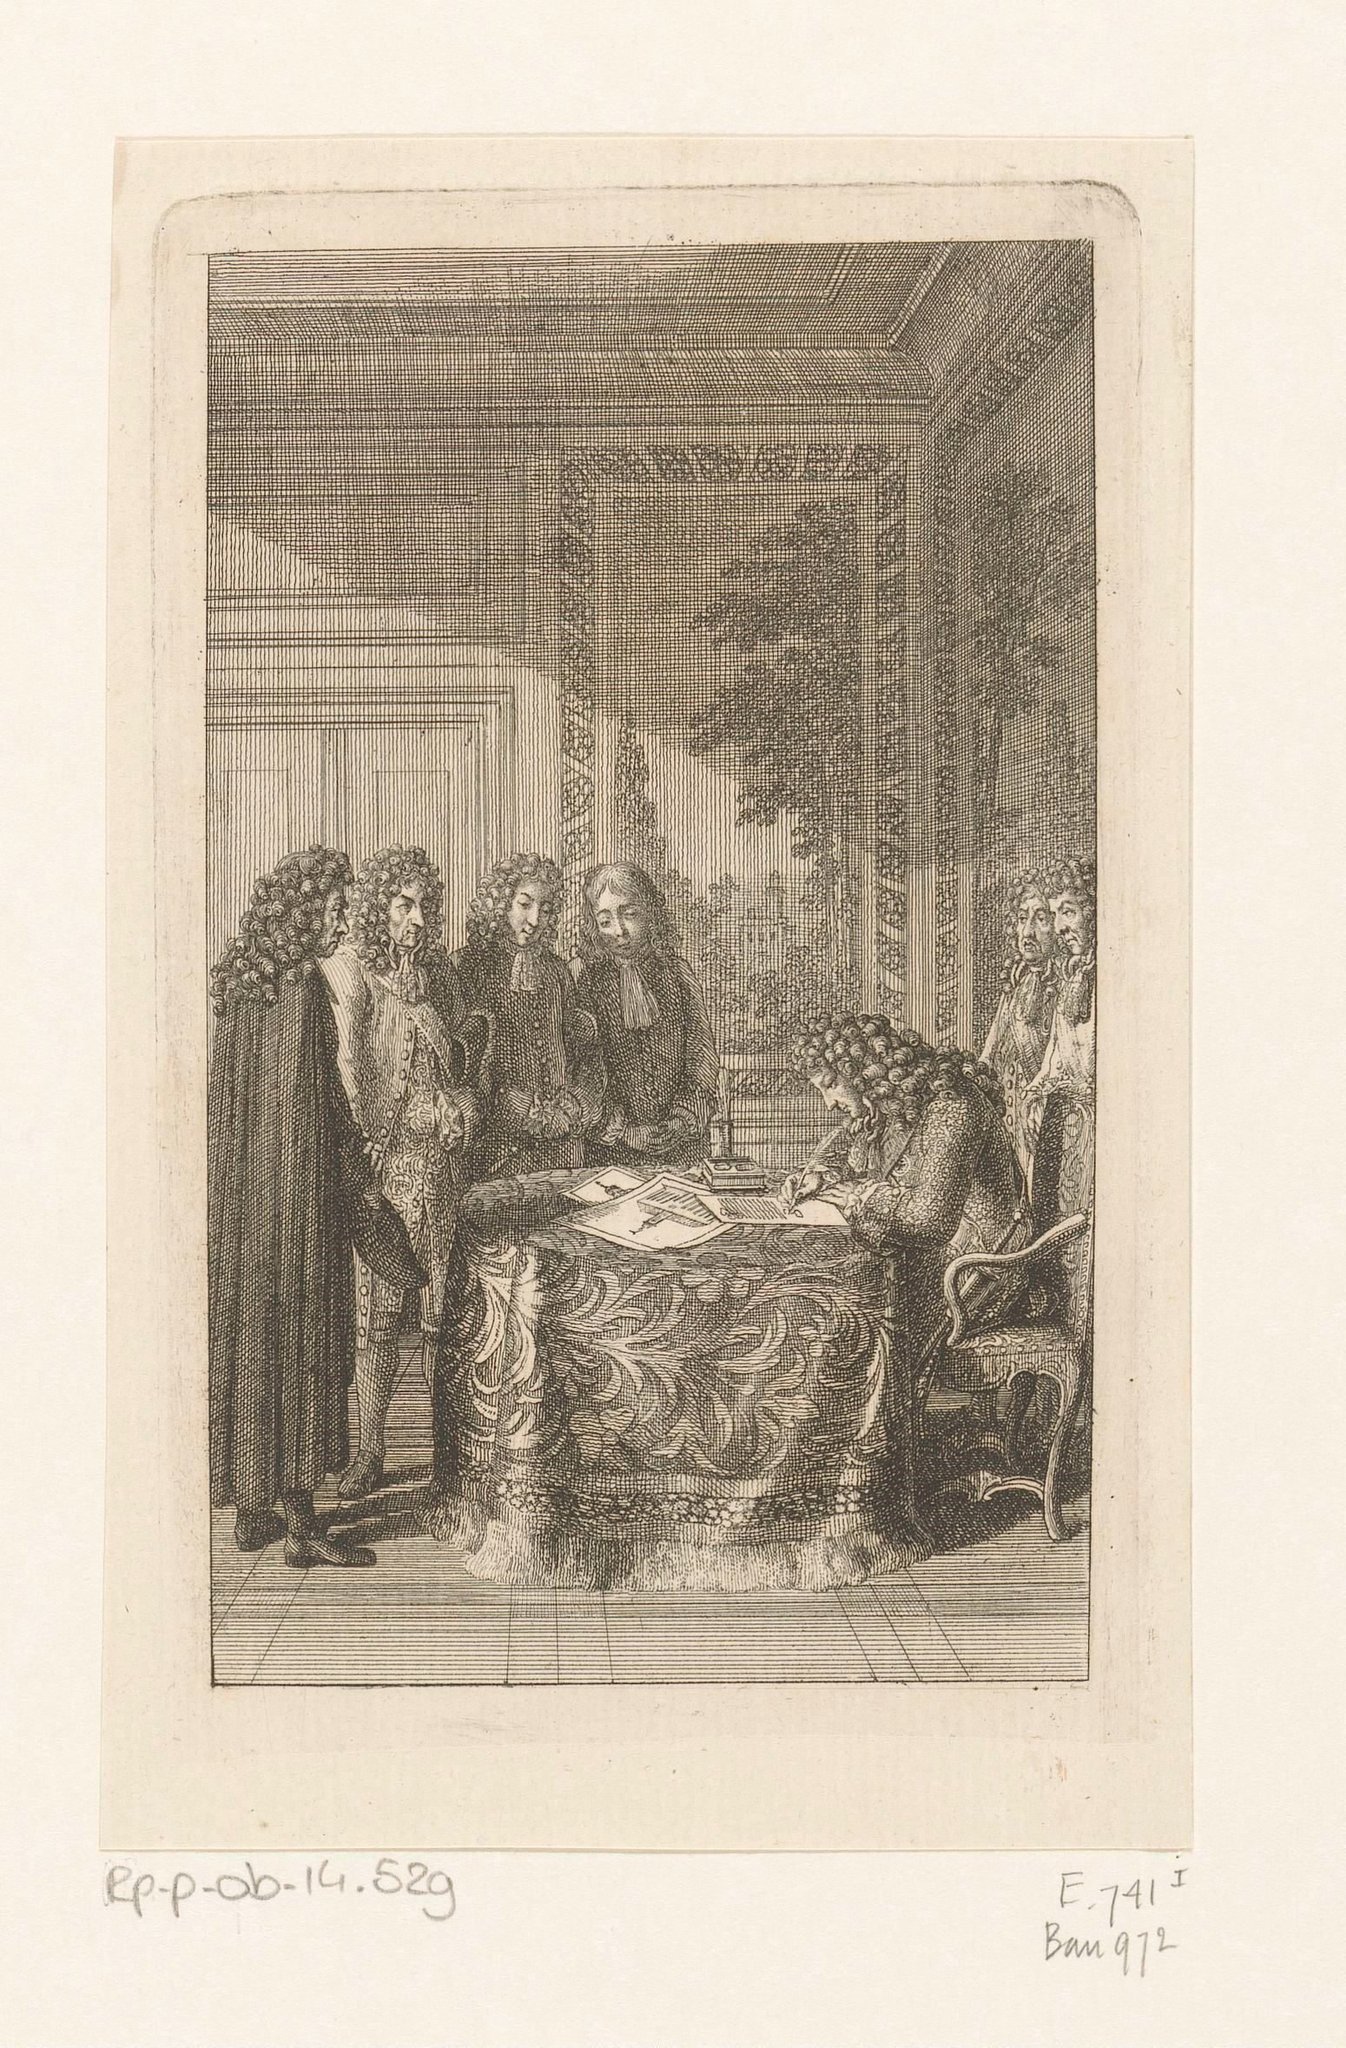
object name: print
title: Friedrich I ondertekent het decreet voor de bouw van de kerk in Friedrichstadt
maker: daniel nikolaus chodowiecki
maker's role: draughtsman, print maker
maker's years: 1726-1801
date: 1794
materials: paper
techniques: etching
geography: berlin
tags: berlin, friedrich i (koning van pruisen), interior of the house, building of church, ruler, sovereign, tapestry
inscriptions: collector's mark: Lugt 2228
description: Prent gebruikt voor: Erman, Jean Pierre. Mémoires pour servir à l'histoire des réfugiés françois dans les états du roi. 9 dln. Berlijn: Fred. Barbiez, 1794, dl. 8.